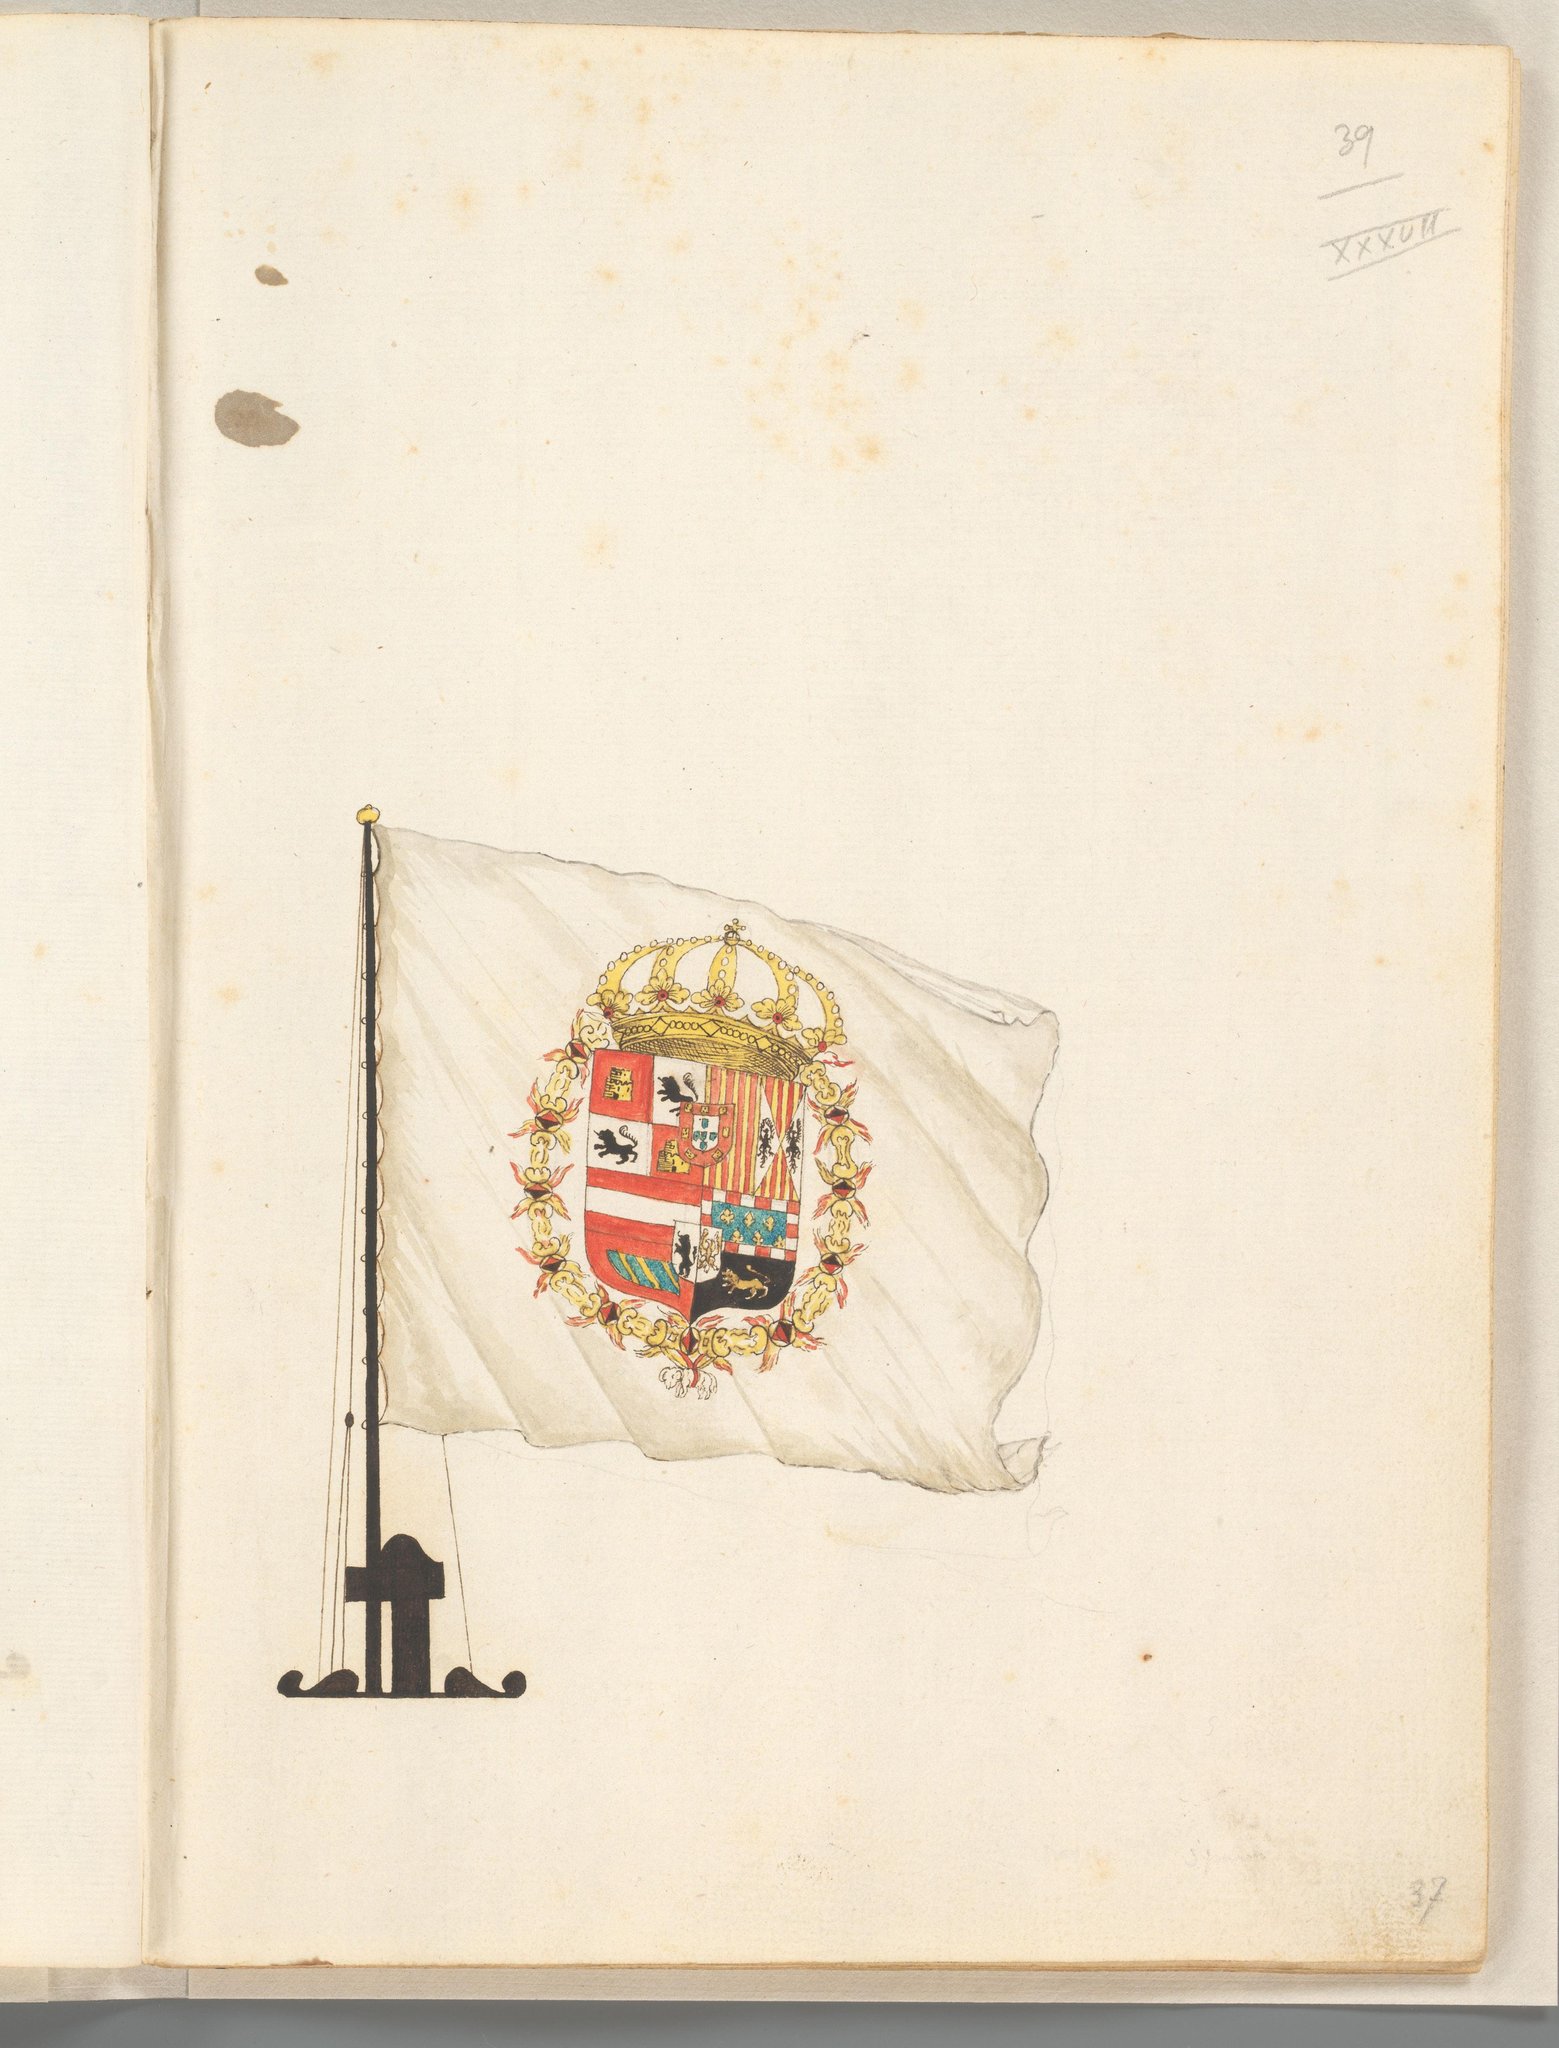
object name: drawing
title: Vlag van Spanje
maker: Anonymous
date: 1667-1670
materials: ink, paper, watercolor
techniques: brush, pen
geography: france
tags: flag, colours (as symbol of the state, etc.), spain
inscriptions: number: ‘39 / XXXVII / 37’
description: Vlag van Spanje. Witte vlag met het gekroonde wapen van het Spaans-Habsburgse koningshuis en waaromheen het ordeteken van het Gulden Vlies. Vlag op vlaggensteng en mastvoet. Afgebeeld op folio 20r. Onderdeel van een vlaggenboek met vlaggen uit Europa, Noord-Afrika, Nabije en Verre Oosten.